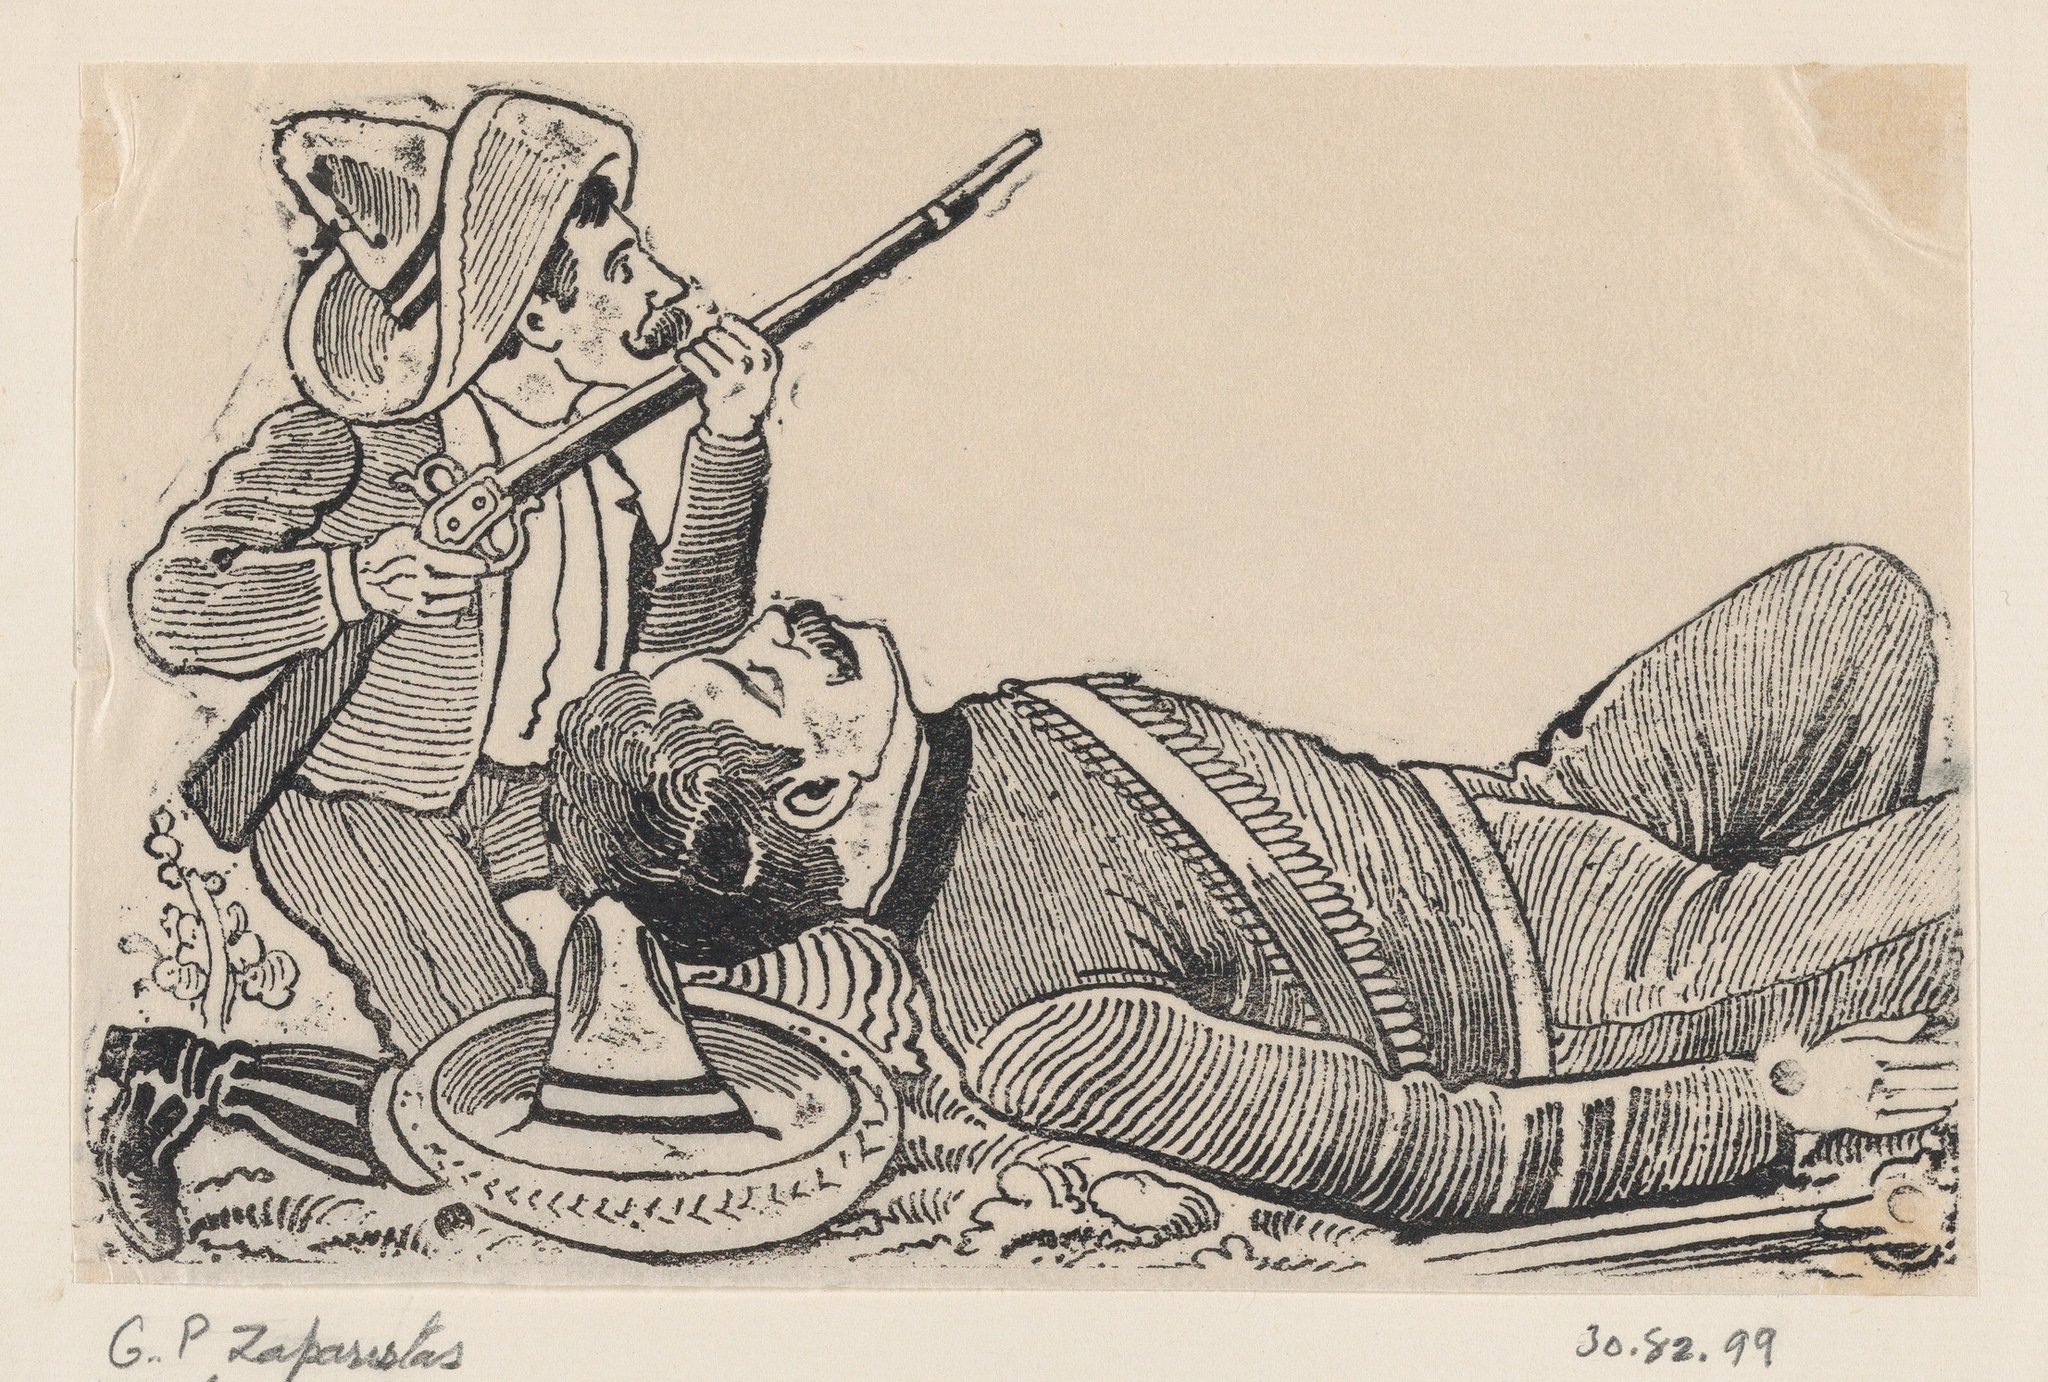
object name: print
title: A revolutionary holding a rifle and kneeling to protect a fallen revolutionary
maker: josé guadalupe posada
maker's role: artist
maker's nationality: mexican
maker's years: 1852-1913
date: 1880-1910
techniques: lithography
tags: firearms,men